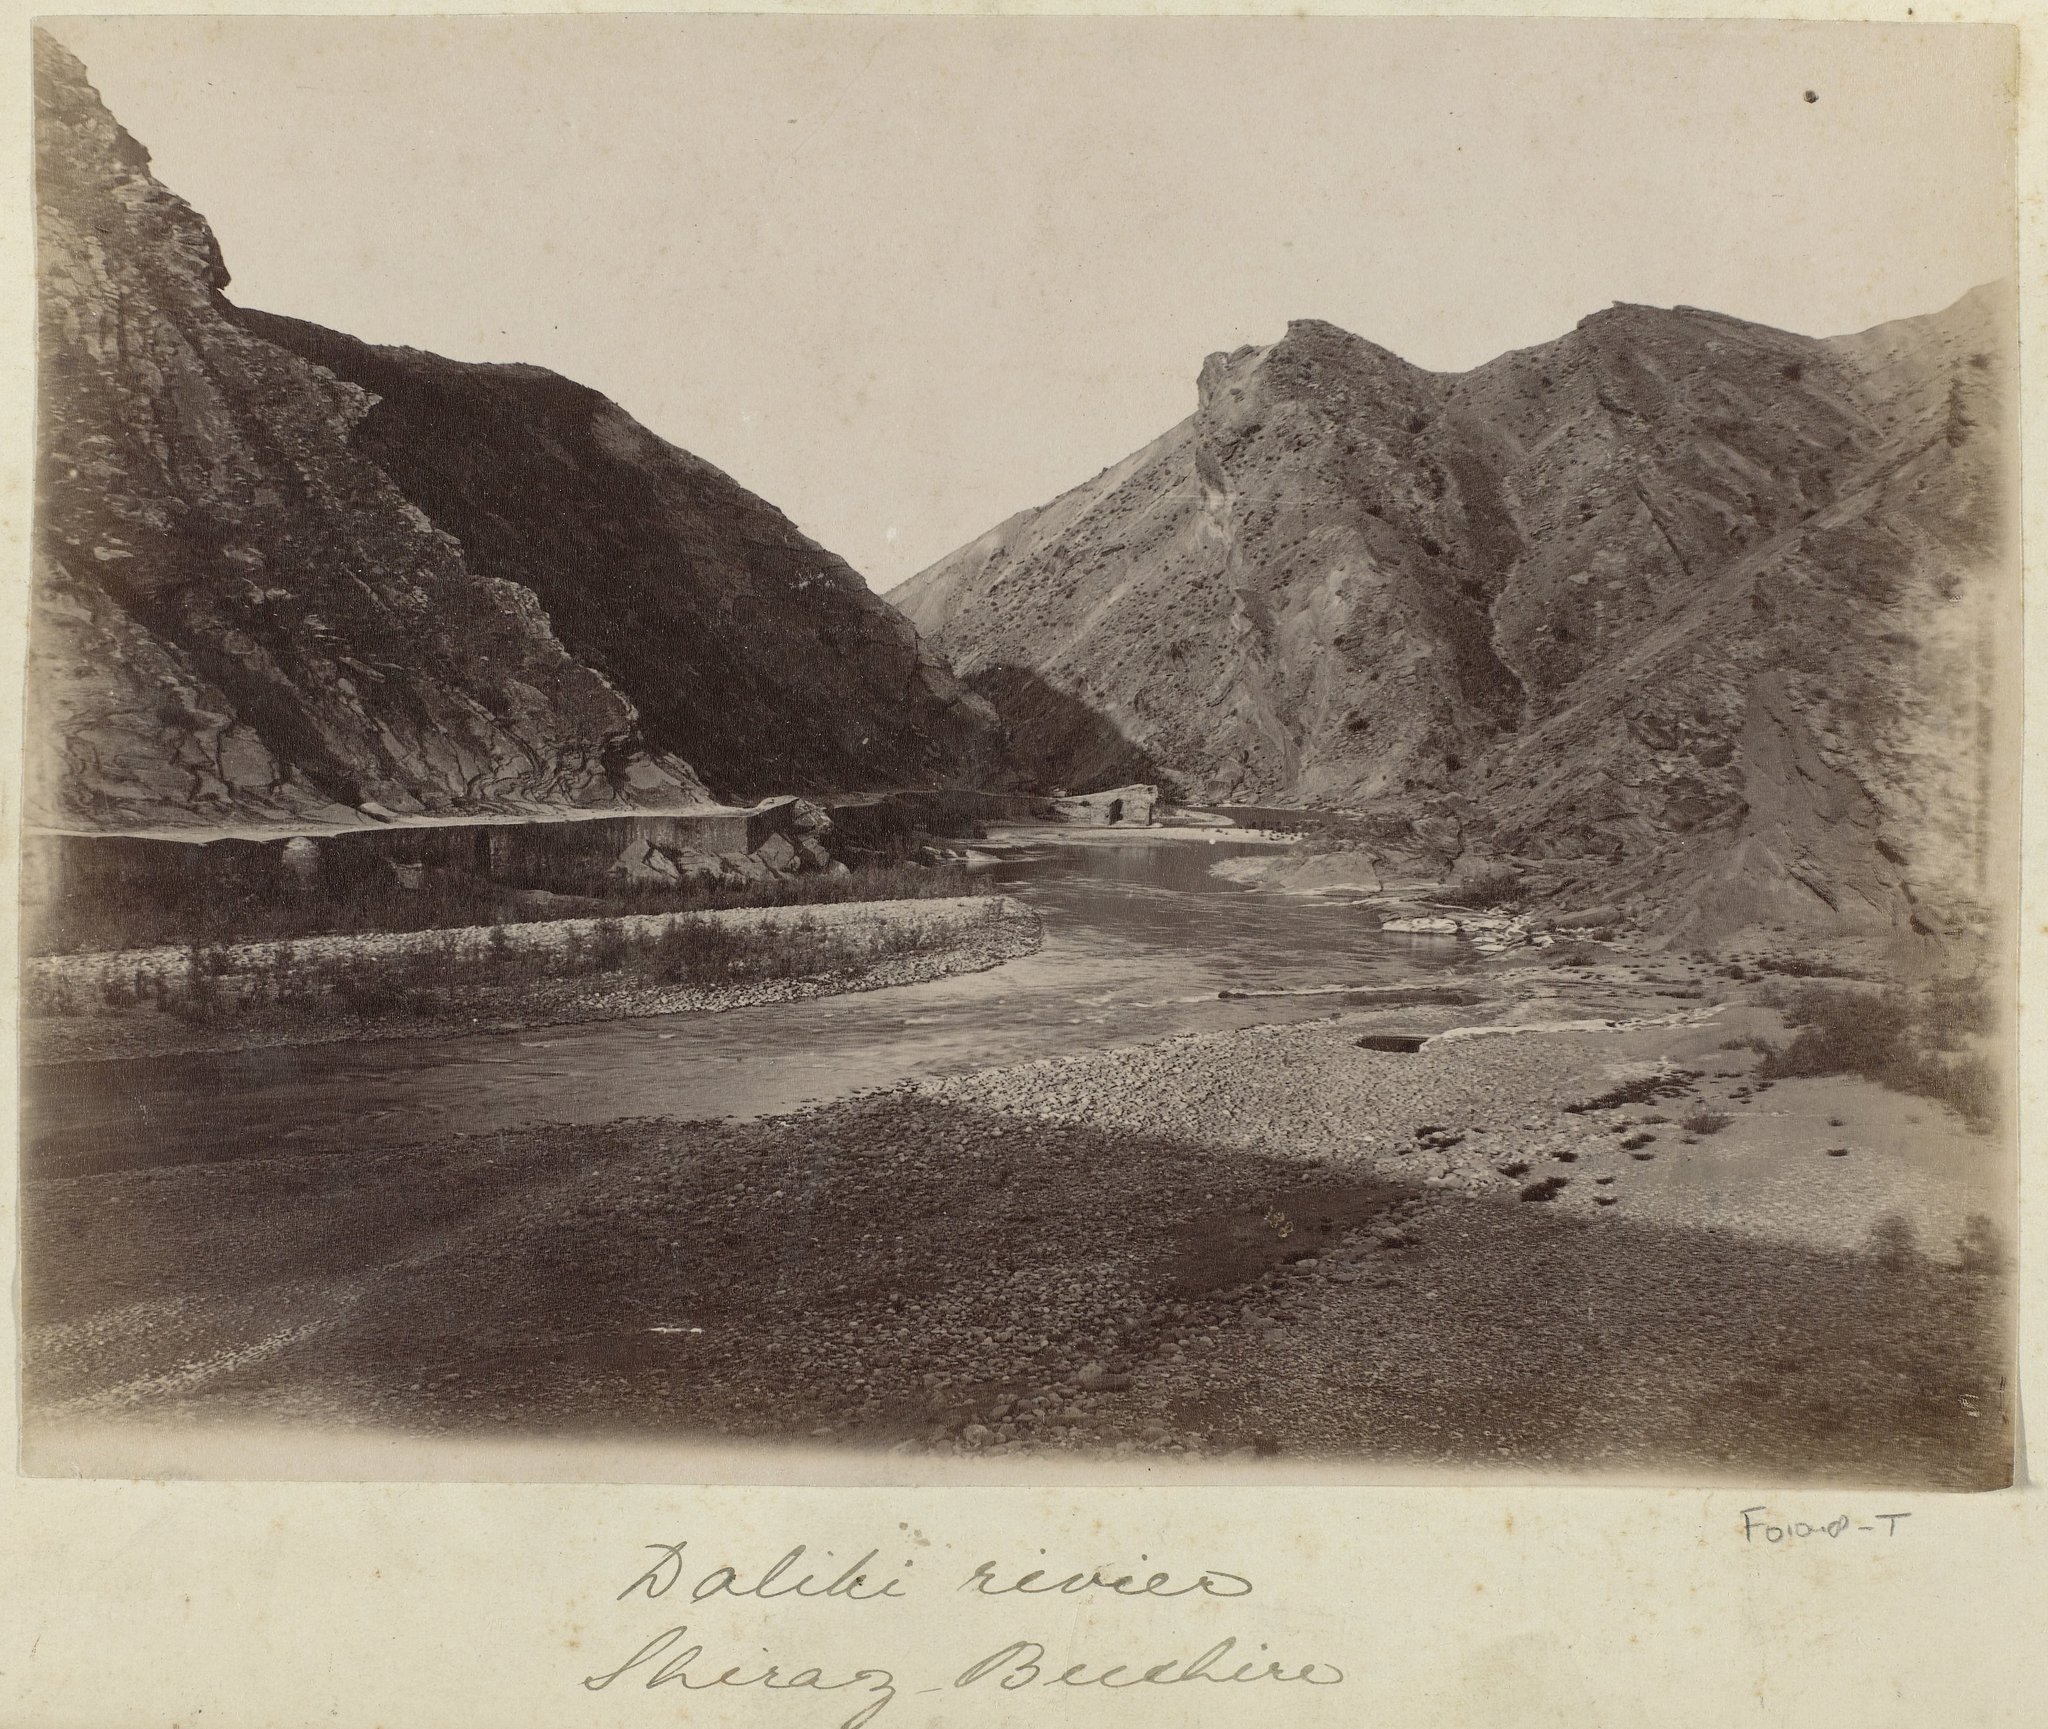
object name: photograph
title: Gezicht op de rivier de Daliki en bergen in Perzië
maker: antoine sevruguin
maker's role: fotograaf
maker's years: 1840-1933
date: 1880-1895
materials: paper, photographic support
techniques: albumen print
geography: iran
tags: river, mountains, persia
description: Onderdeel van Reisalbum van H. Dunlop met foto's van bezienswaardigheden in Perzië, Schotland, Duitsland, Rusland, China en Canada.